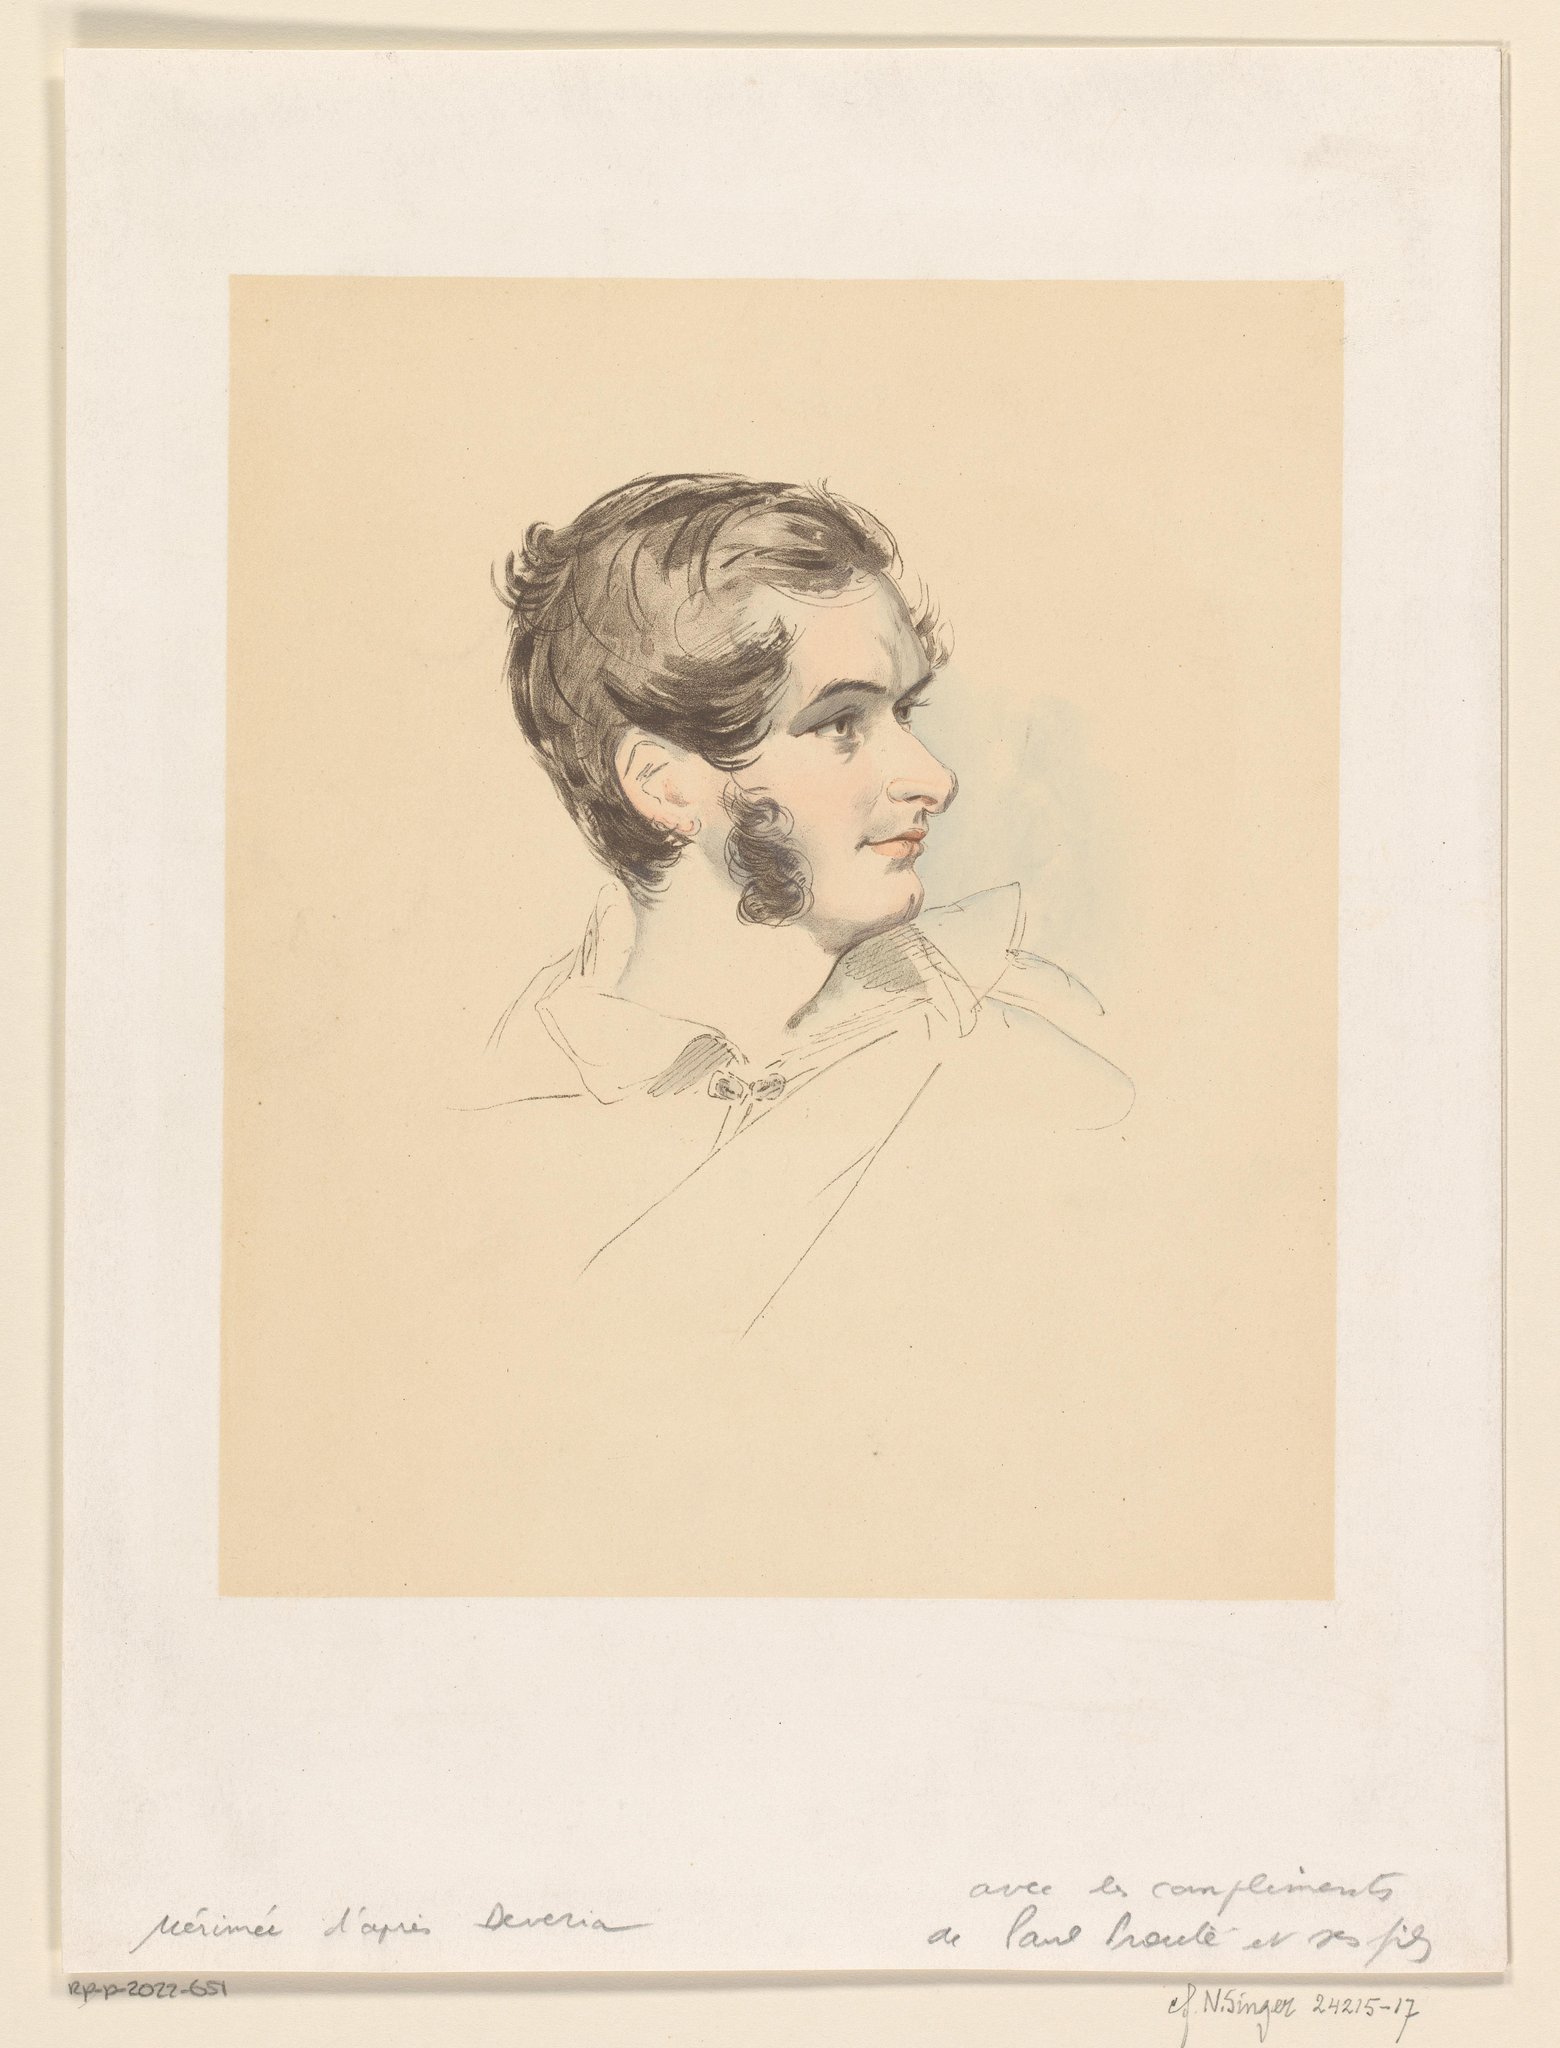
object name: print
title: Portret van Prosper Mérimée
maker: Anonymous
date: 1820-1950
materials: paper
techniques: tone lithography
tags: paris, historical persons